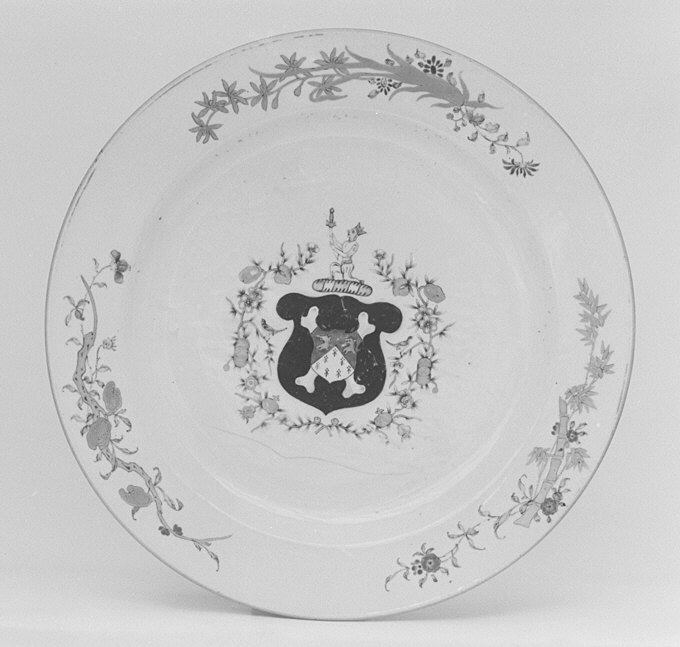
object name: plate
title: Plate (part of a service)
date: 1740-1750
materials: hard paste porcelain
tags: flowers,coat of arms